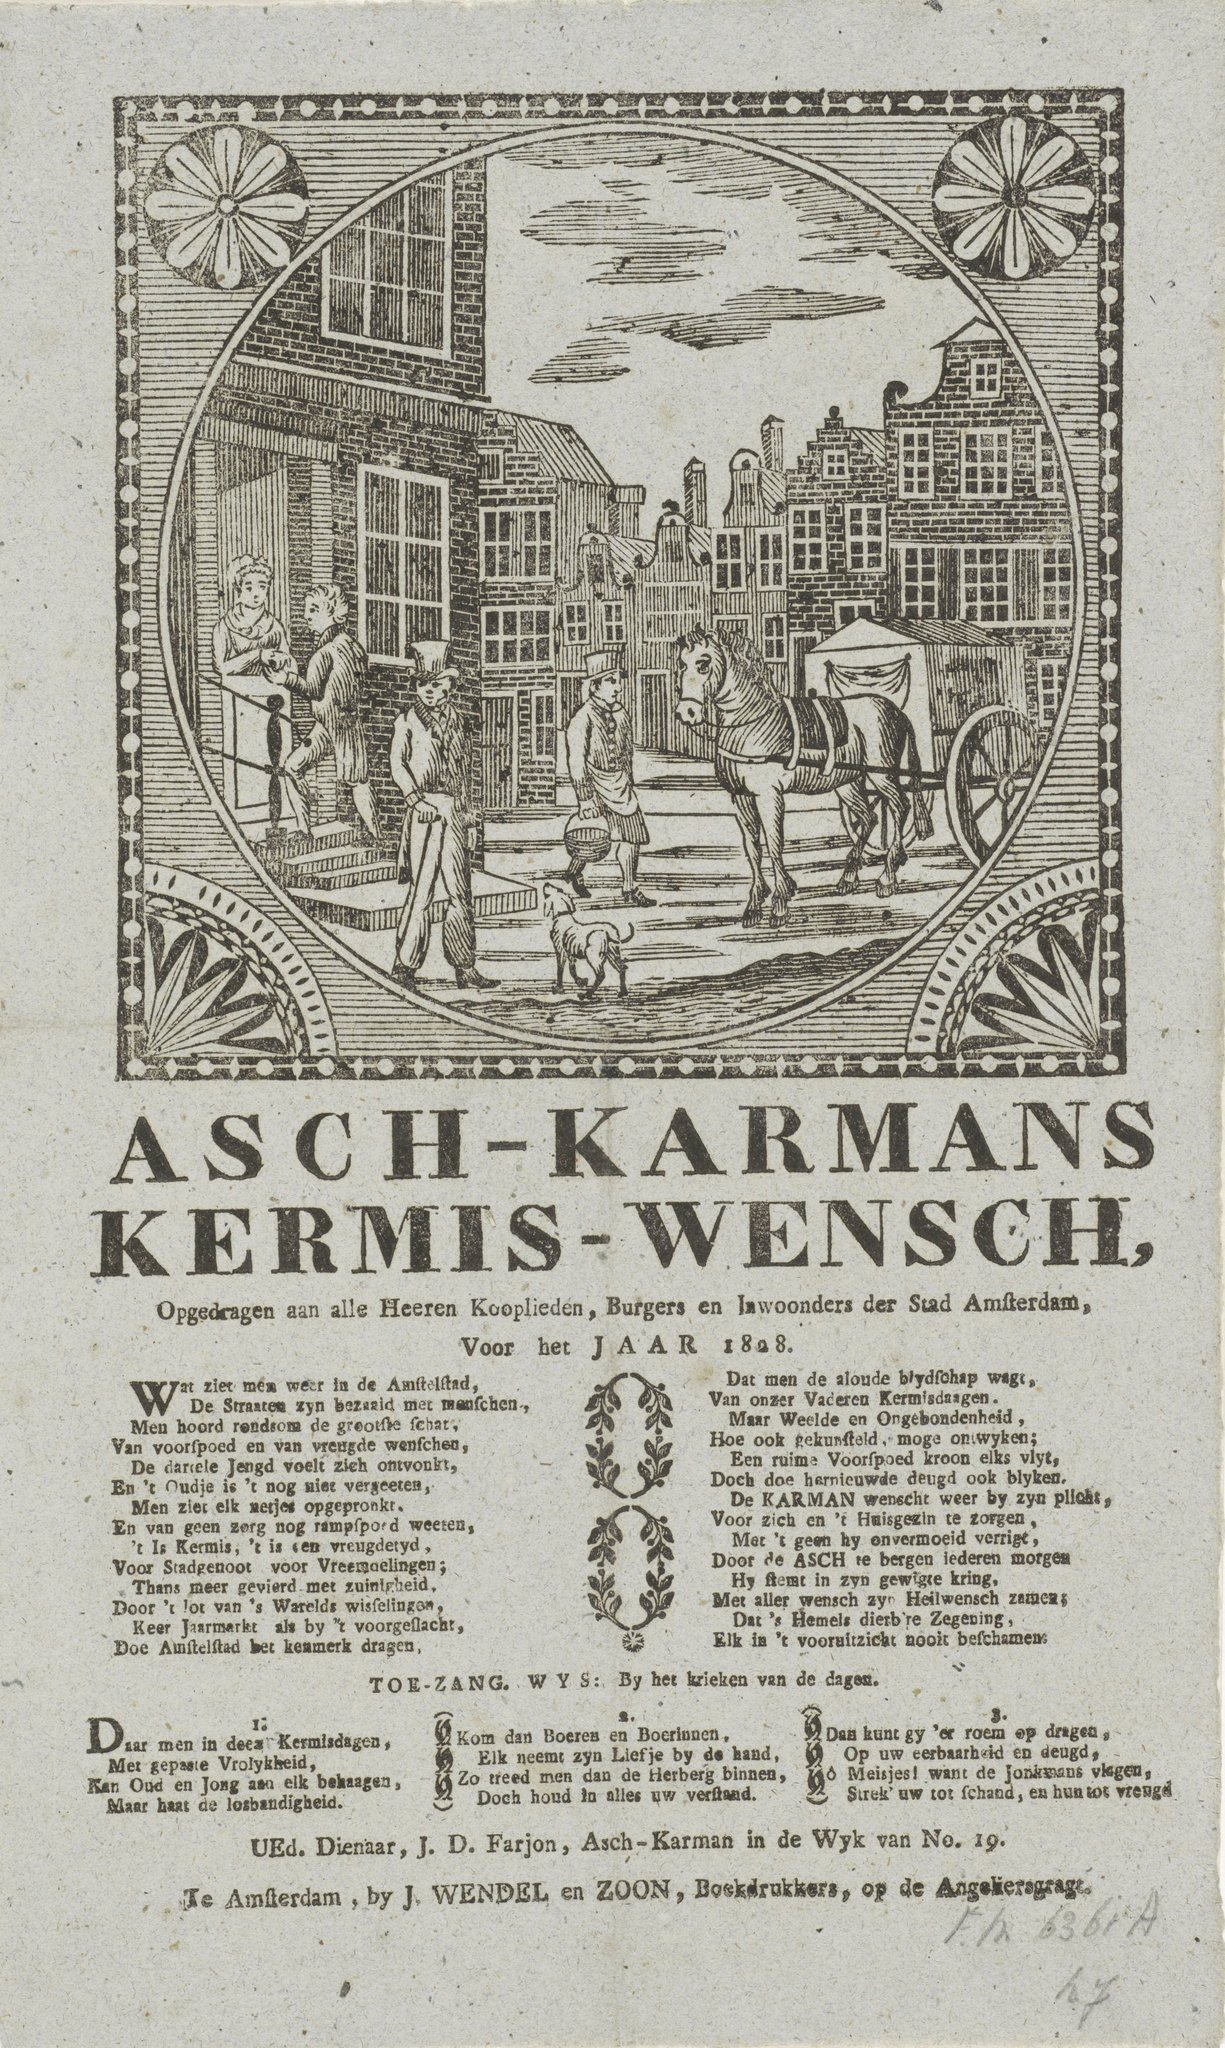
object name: fair print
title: Asch-Karmans Kermis-Wensch (...) 1828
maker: Anonymous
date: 1827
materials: paper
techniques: letterpress printing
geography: amsterdam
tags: public road - ii - ideal city, garbage collection, amsterdam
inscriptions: collector's mark: Lugt 2228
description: Kermisprent namens de askarrenmannen (karrenman of vuilnisman) te Amsterdam voor het jaar 1828. Gezicht in een straat te Amsterdam met een man die een asemmer naar de kar draagt en een man die aan huis geld ophaalt. Onderaan een gedicht in twee kolommen en een lied in drie verzen. Namens J.D. Farjon, de askarreman van wijk no. 19.